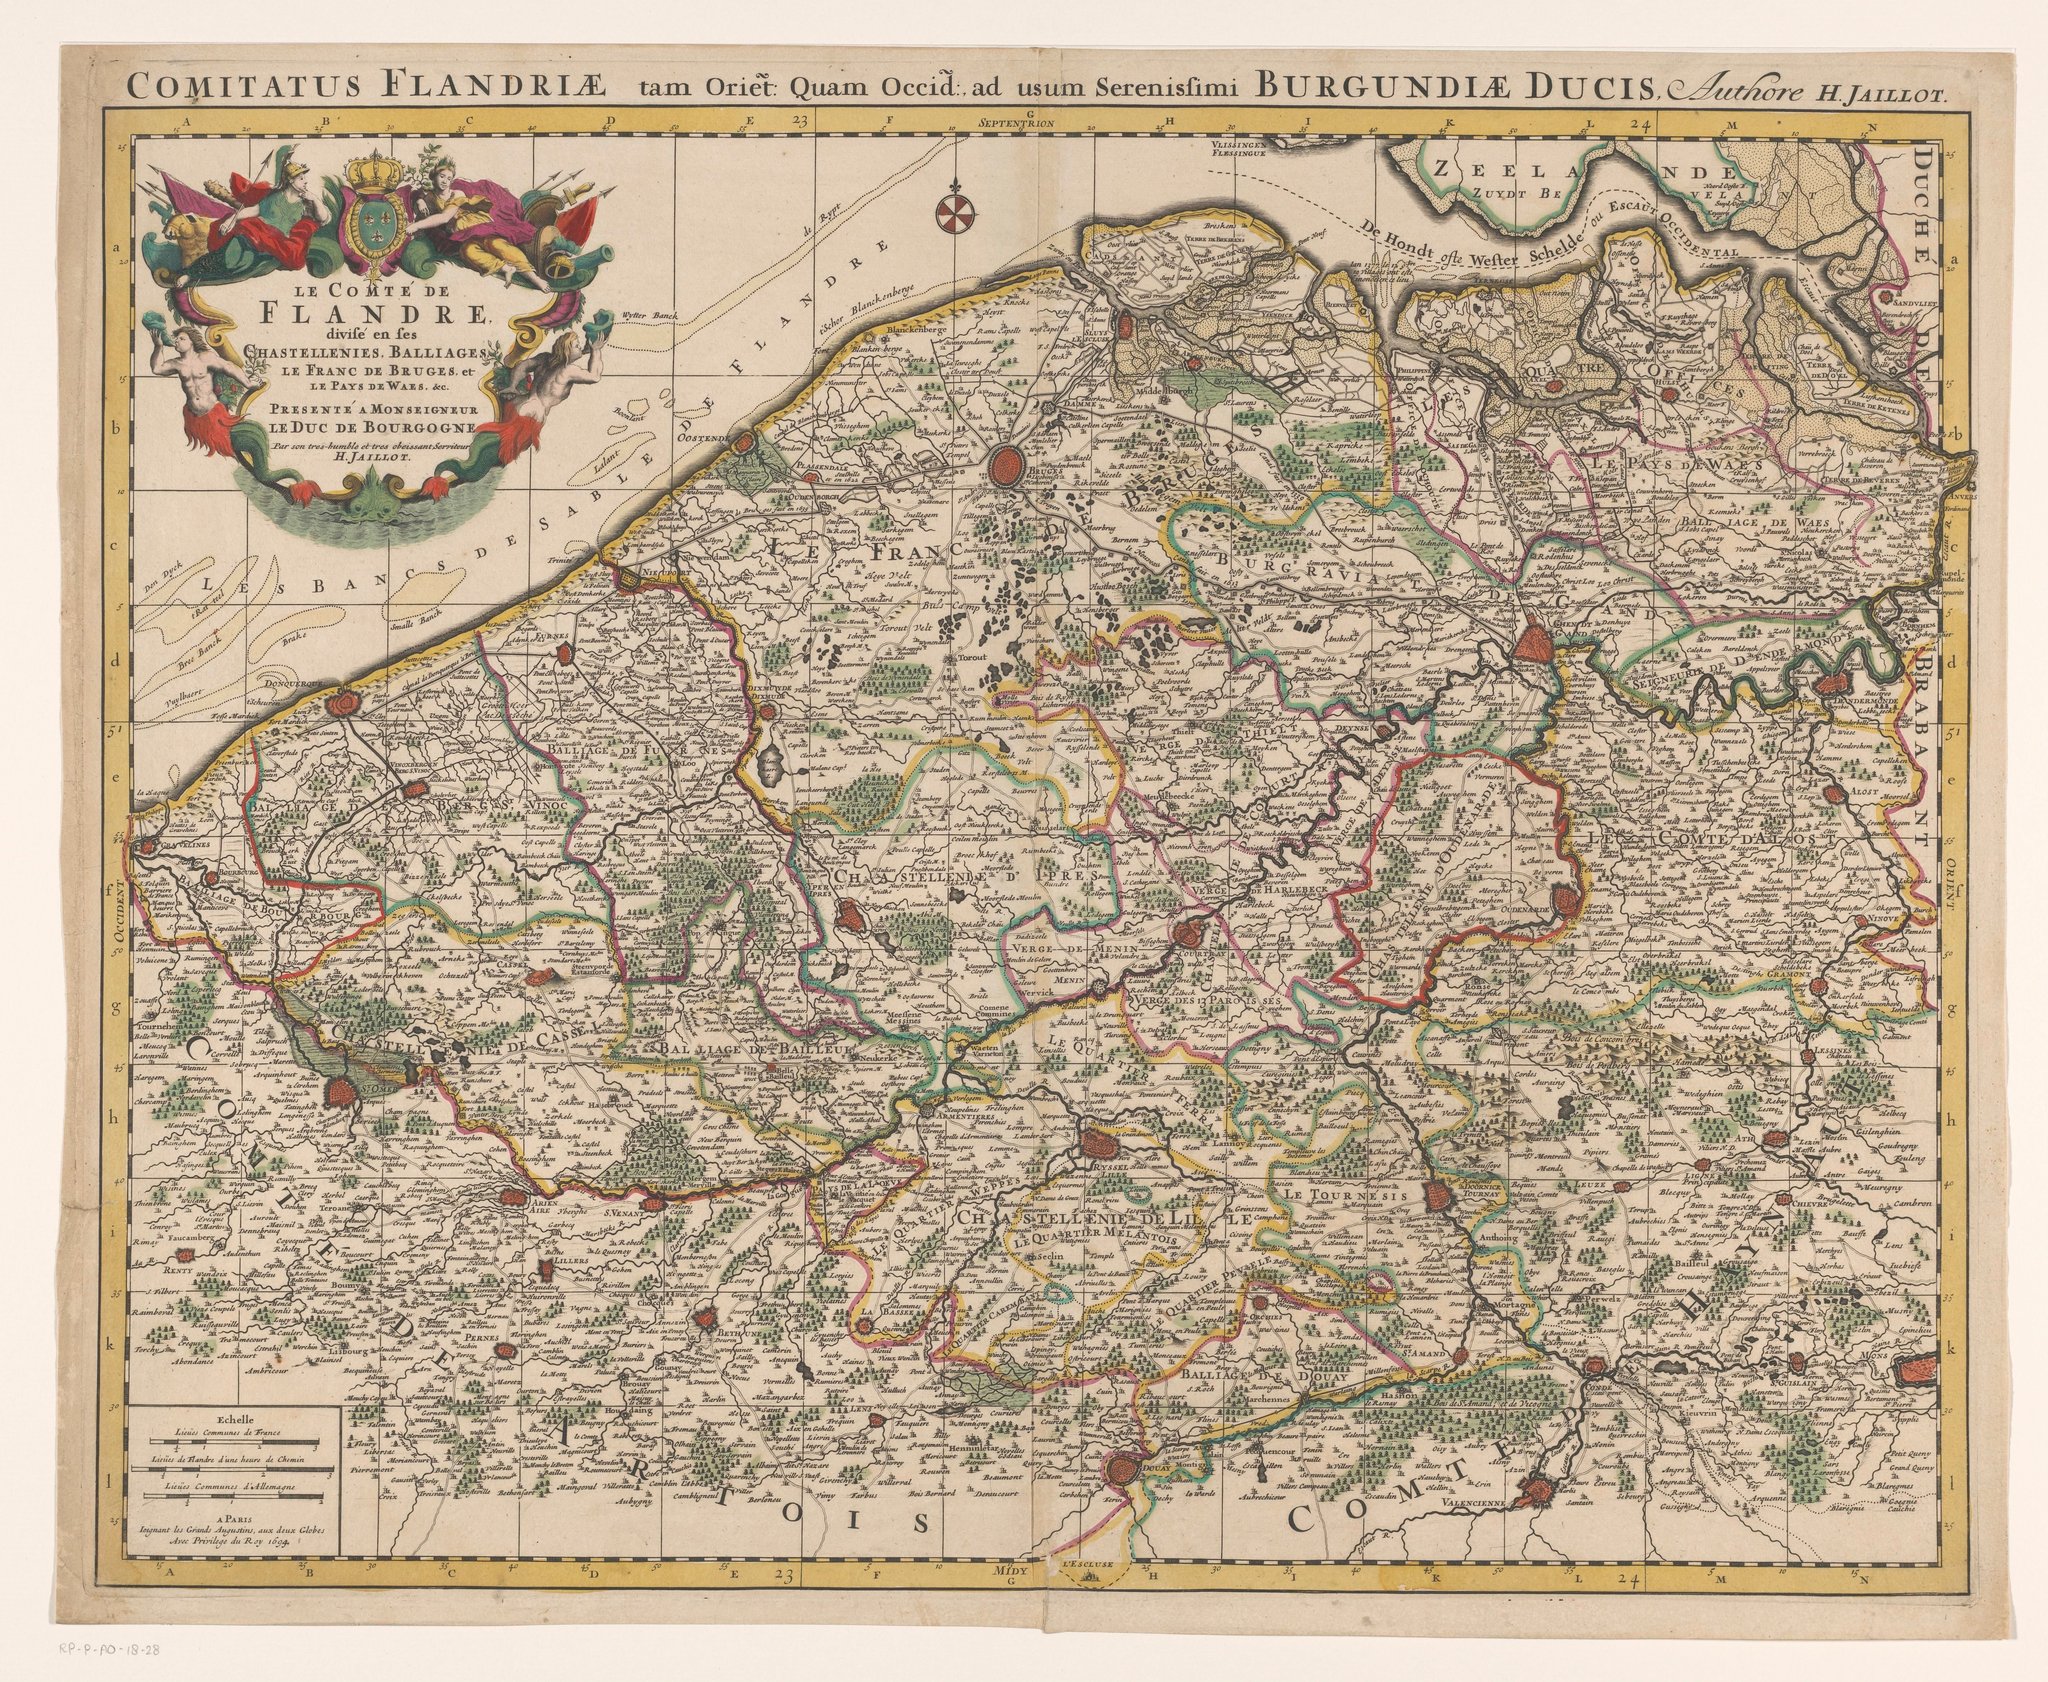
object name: print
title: Comitatus Flandriae tam oriet: quam occid: (...) / Le comté de Flandre divisé en ses Chastellenies, Balliages (...)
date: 1694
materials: paper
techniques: engraving, etching, hand coloring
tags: maps of separate countries or regions, armorial bearing, heraldry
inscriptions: date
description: Kaart van het graafschap Vlaanderen. Boven de kaart een titel en linksboven een cartouche met tweede titel, met bovenin het wapen van de koning van Frankrijk. Linksonder een kader met drie schaalstokken: 3 Lieües Communes de France / 3 Lieües de Flandre d'une heure de Chemin / 2 Lieües Communes d'Allemagne. De kaart is voorzien van een zoekrooster en een gradenverdeling langs de randen.